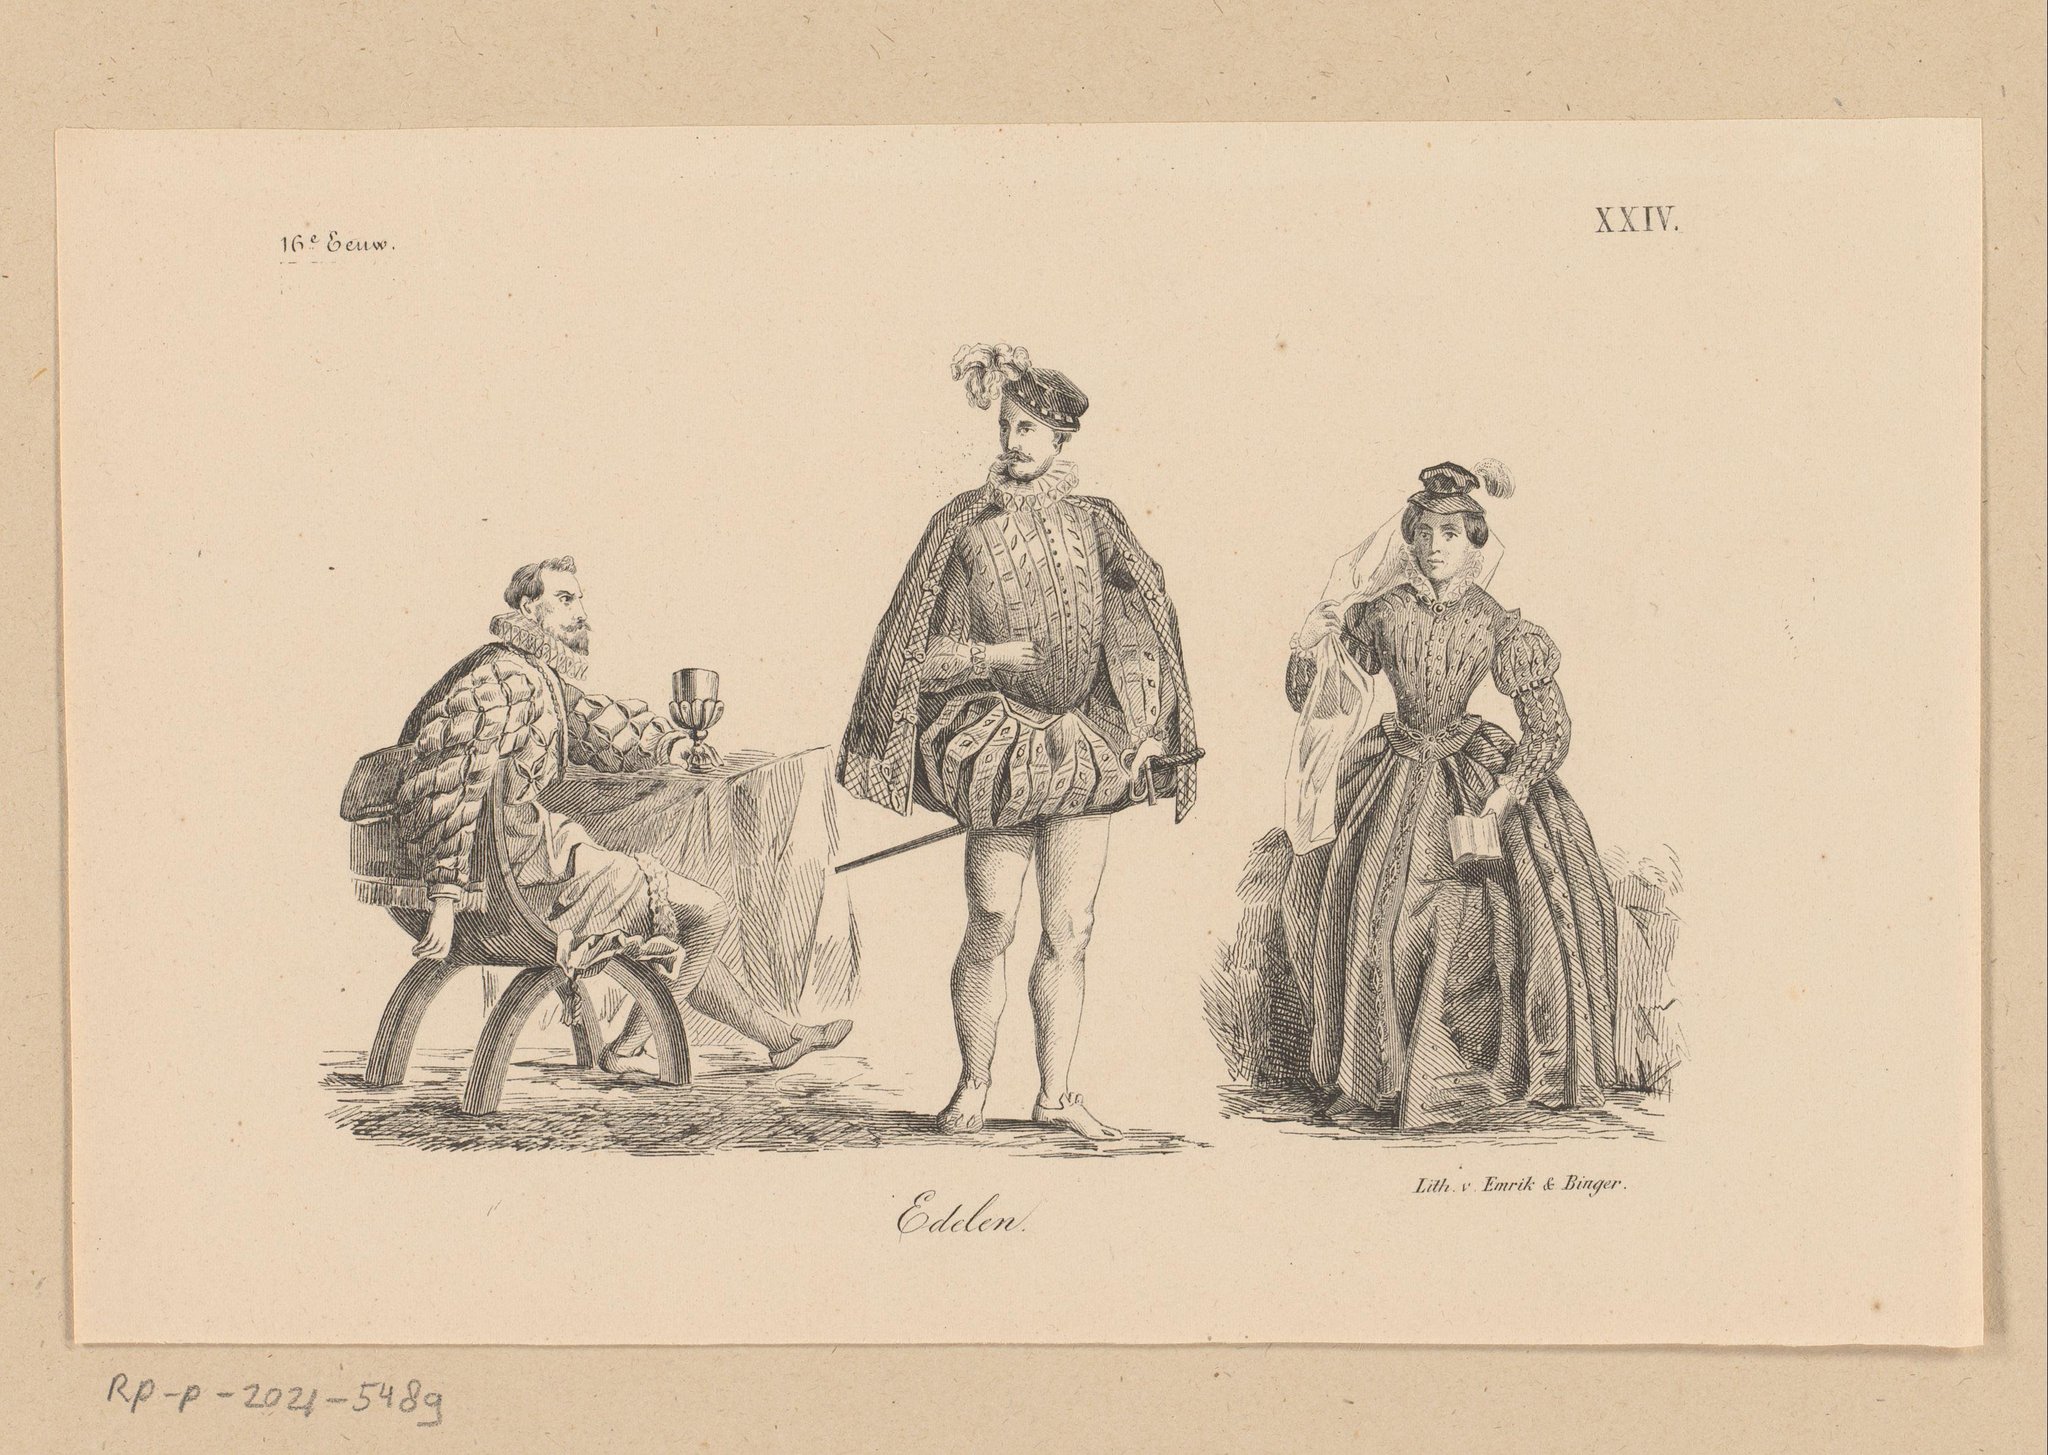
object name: book illustration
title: Edelen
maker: Anonymous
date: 1857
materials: paper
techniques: lithograph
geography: haarlem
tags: hacking and thrusting weapons: sword, clothes, costume, nobility and patriciate; chivalry, knighthood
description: Prent waarschijnlijk uit: Hofdijk, Willem Jacob. Schets van de geschiedenis der Nederlanden. Amsterdam: Gebroeders Binger, 1857.